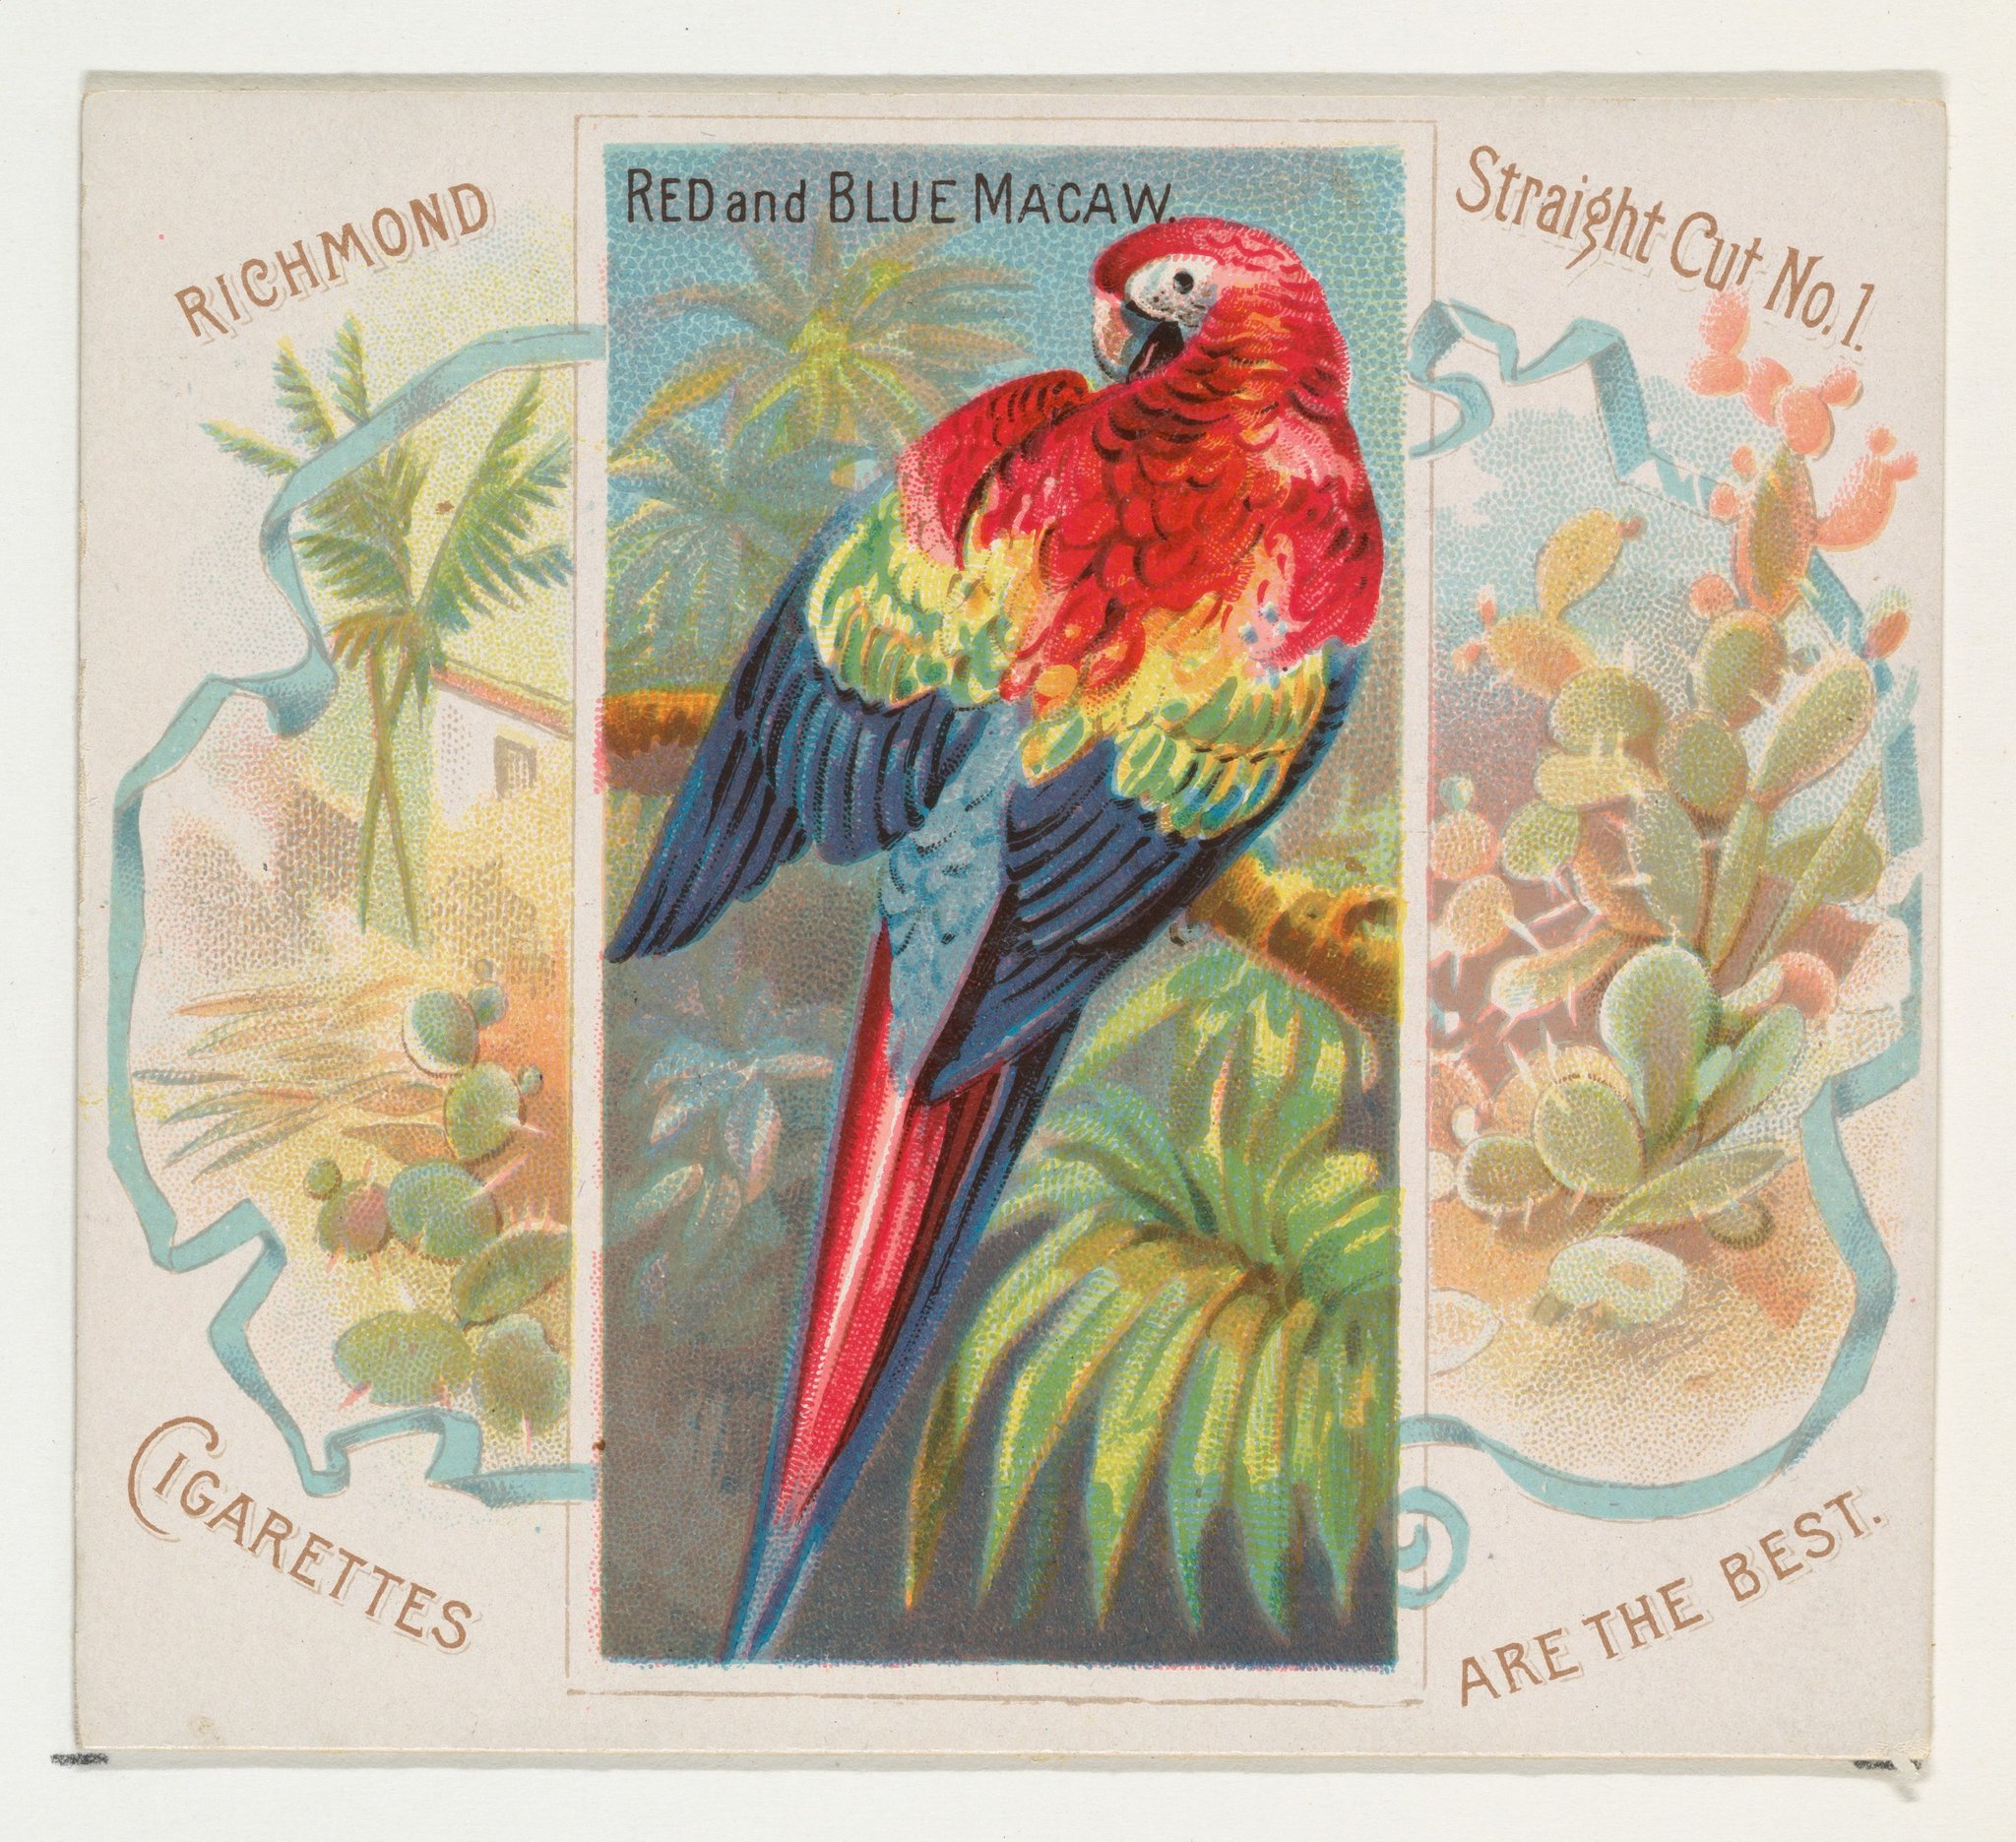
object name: print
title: Red and Blue Macaw, from Birds of the Tropics series (N38) for Allen & Ginter Cigarettes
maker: allen & ginter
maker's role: publisher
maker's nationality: american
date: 1889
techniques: color lithograph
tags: birds